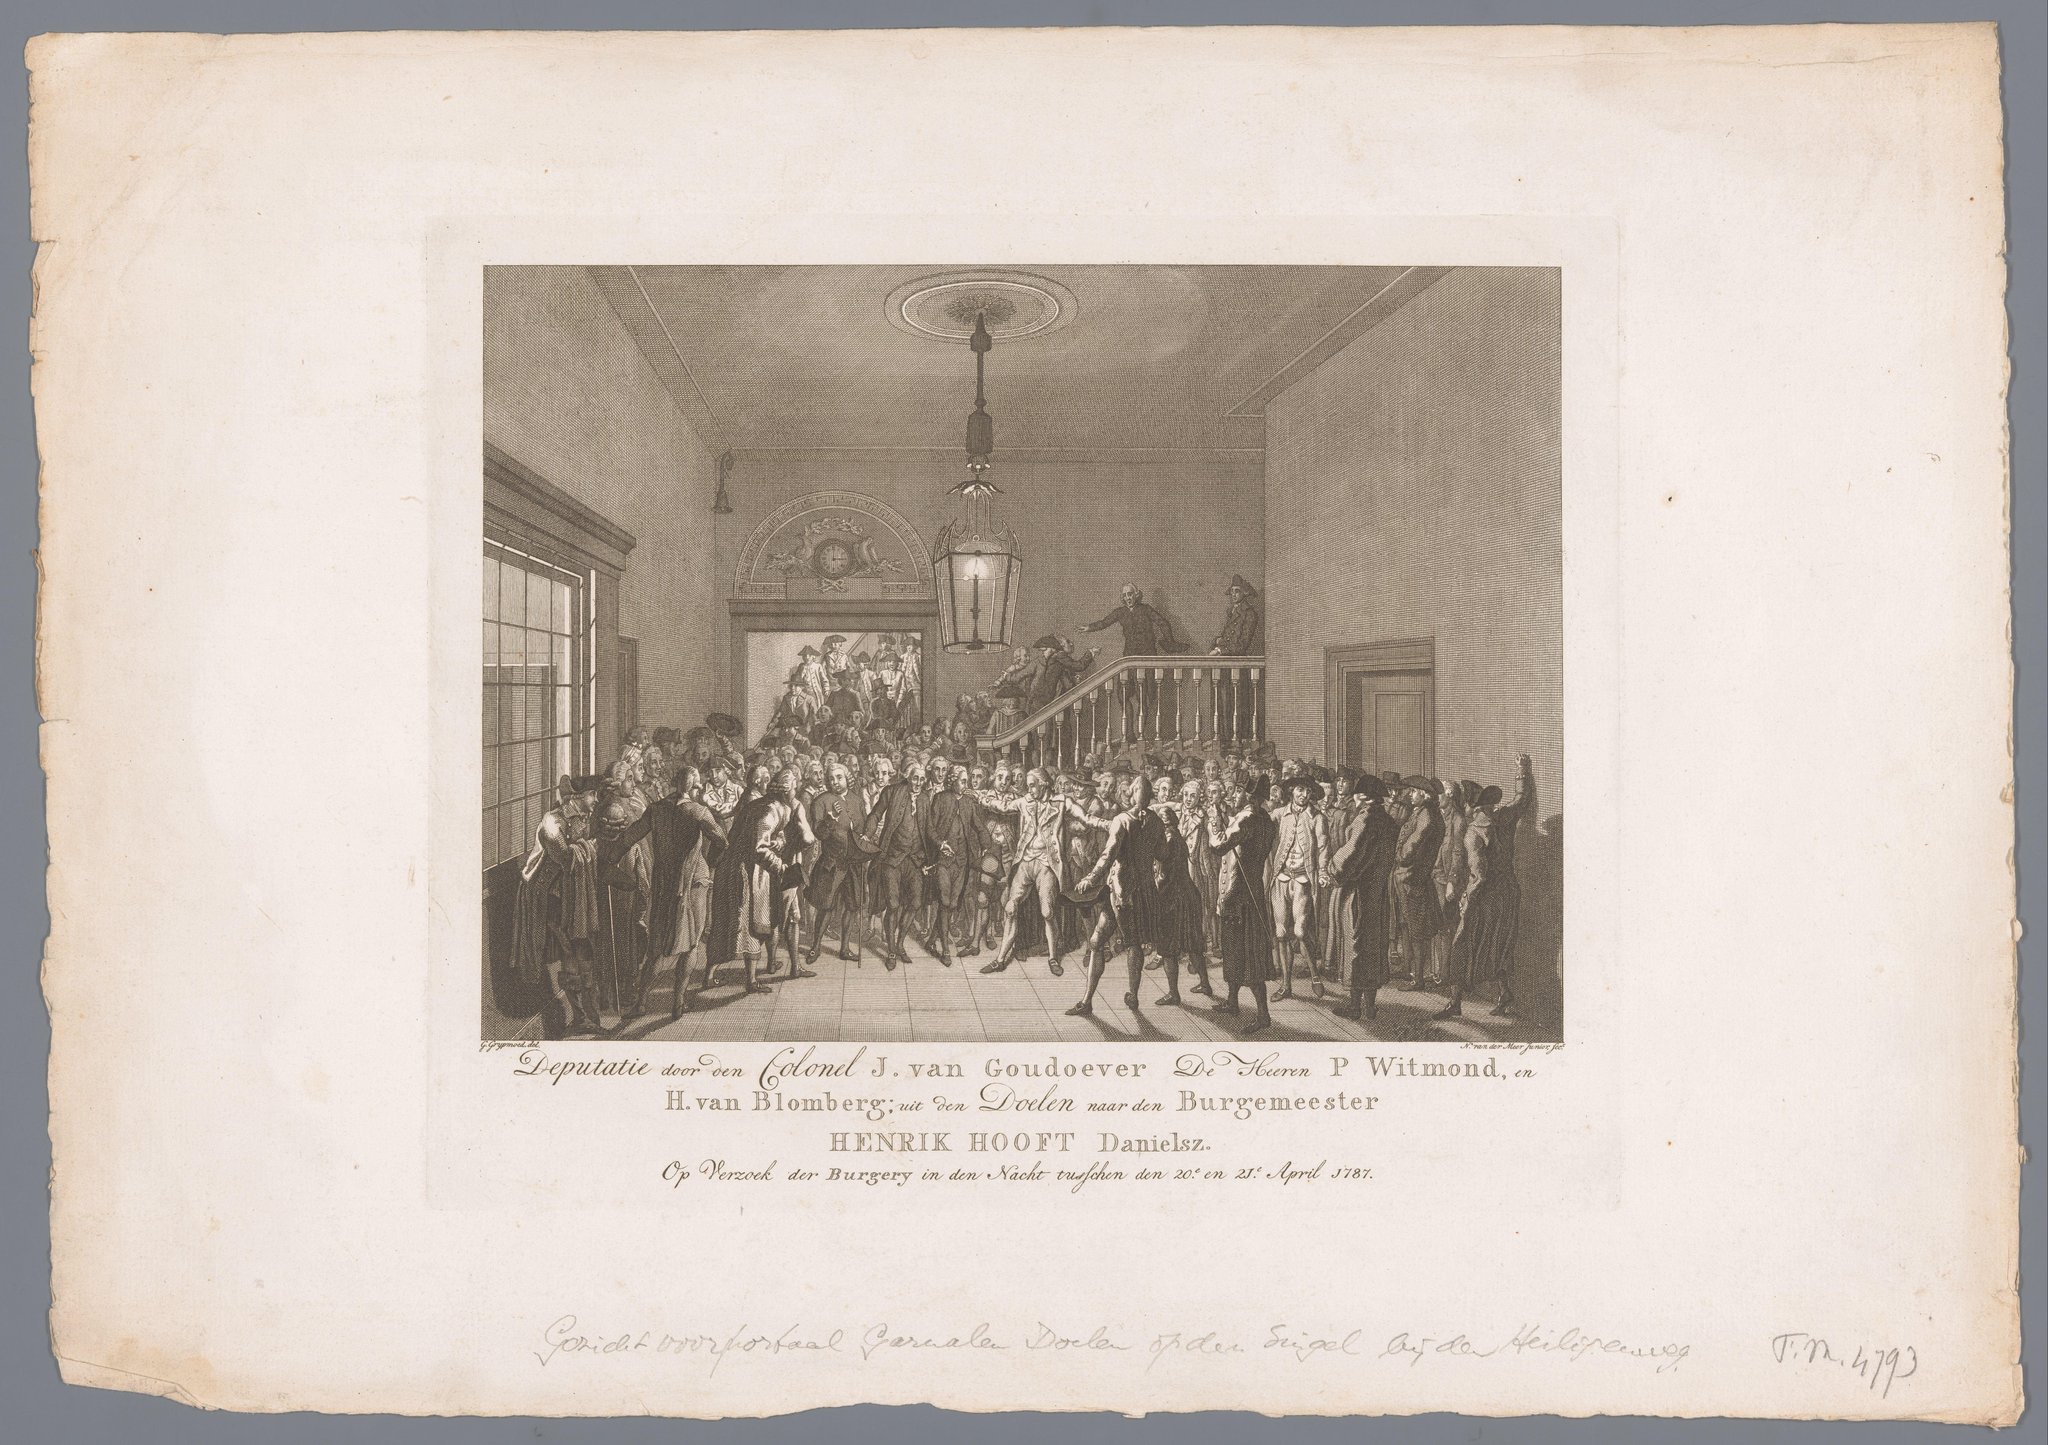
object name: print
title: Deputatie door den Colonel J. van Goudoever De heeren P Witmond, en H. van Blomberg; uit den Doelen naar den Burgemeester Henrik Hooft Danielsz. Op Verzoek der Burgery in den Nacht tusschen den 20e. en 21e. April 1787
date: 1787-1789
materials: paper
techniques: engraving, etching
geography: amsterdam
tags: amsterdam, mayor, hendrik danielsz. hooft, revolutionary council, patriots (1780-1795)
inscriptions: collector's mark: Lugt 2233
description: Een deputatie bestaande uit kolonel Isaak van Goudoever, Pieter Witmond en Hendrik van Blomberg vanuit de Garnalendoelen naar burgemeester Hendrik Danielsz. Hooft met het verzoek namens de burgerij van Amsterdam om de remotie van negen raadsleden, in de nacht van 20 op 21 april 1787.